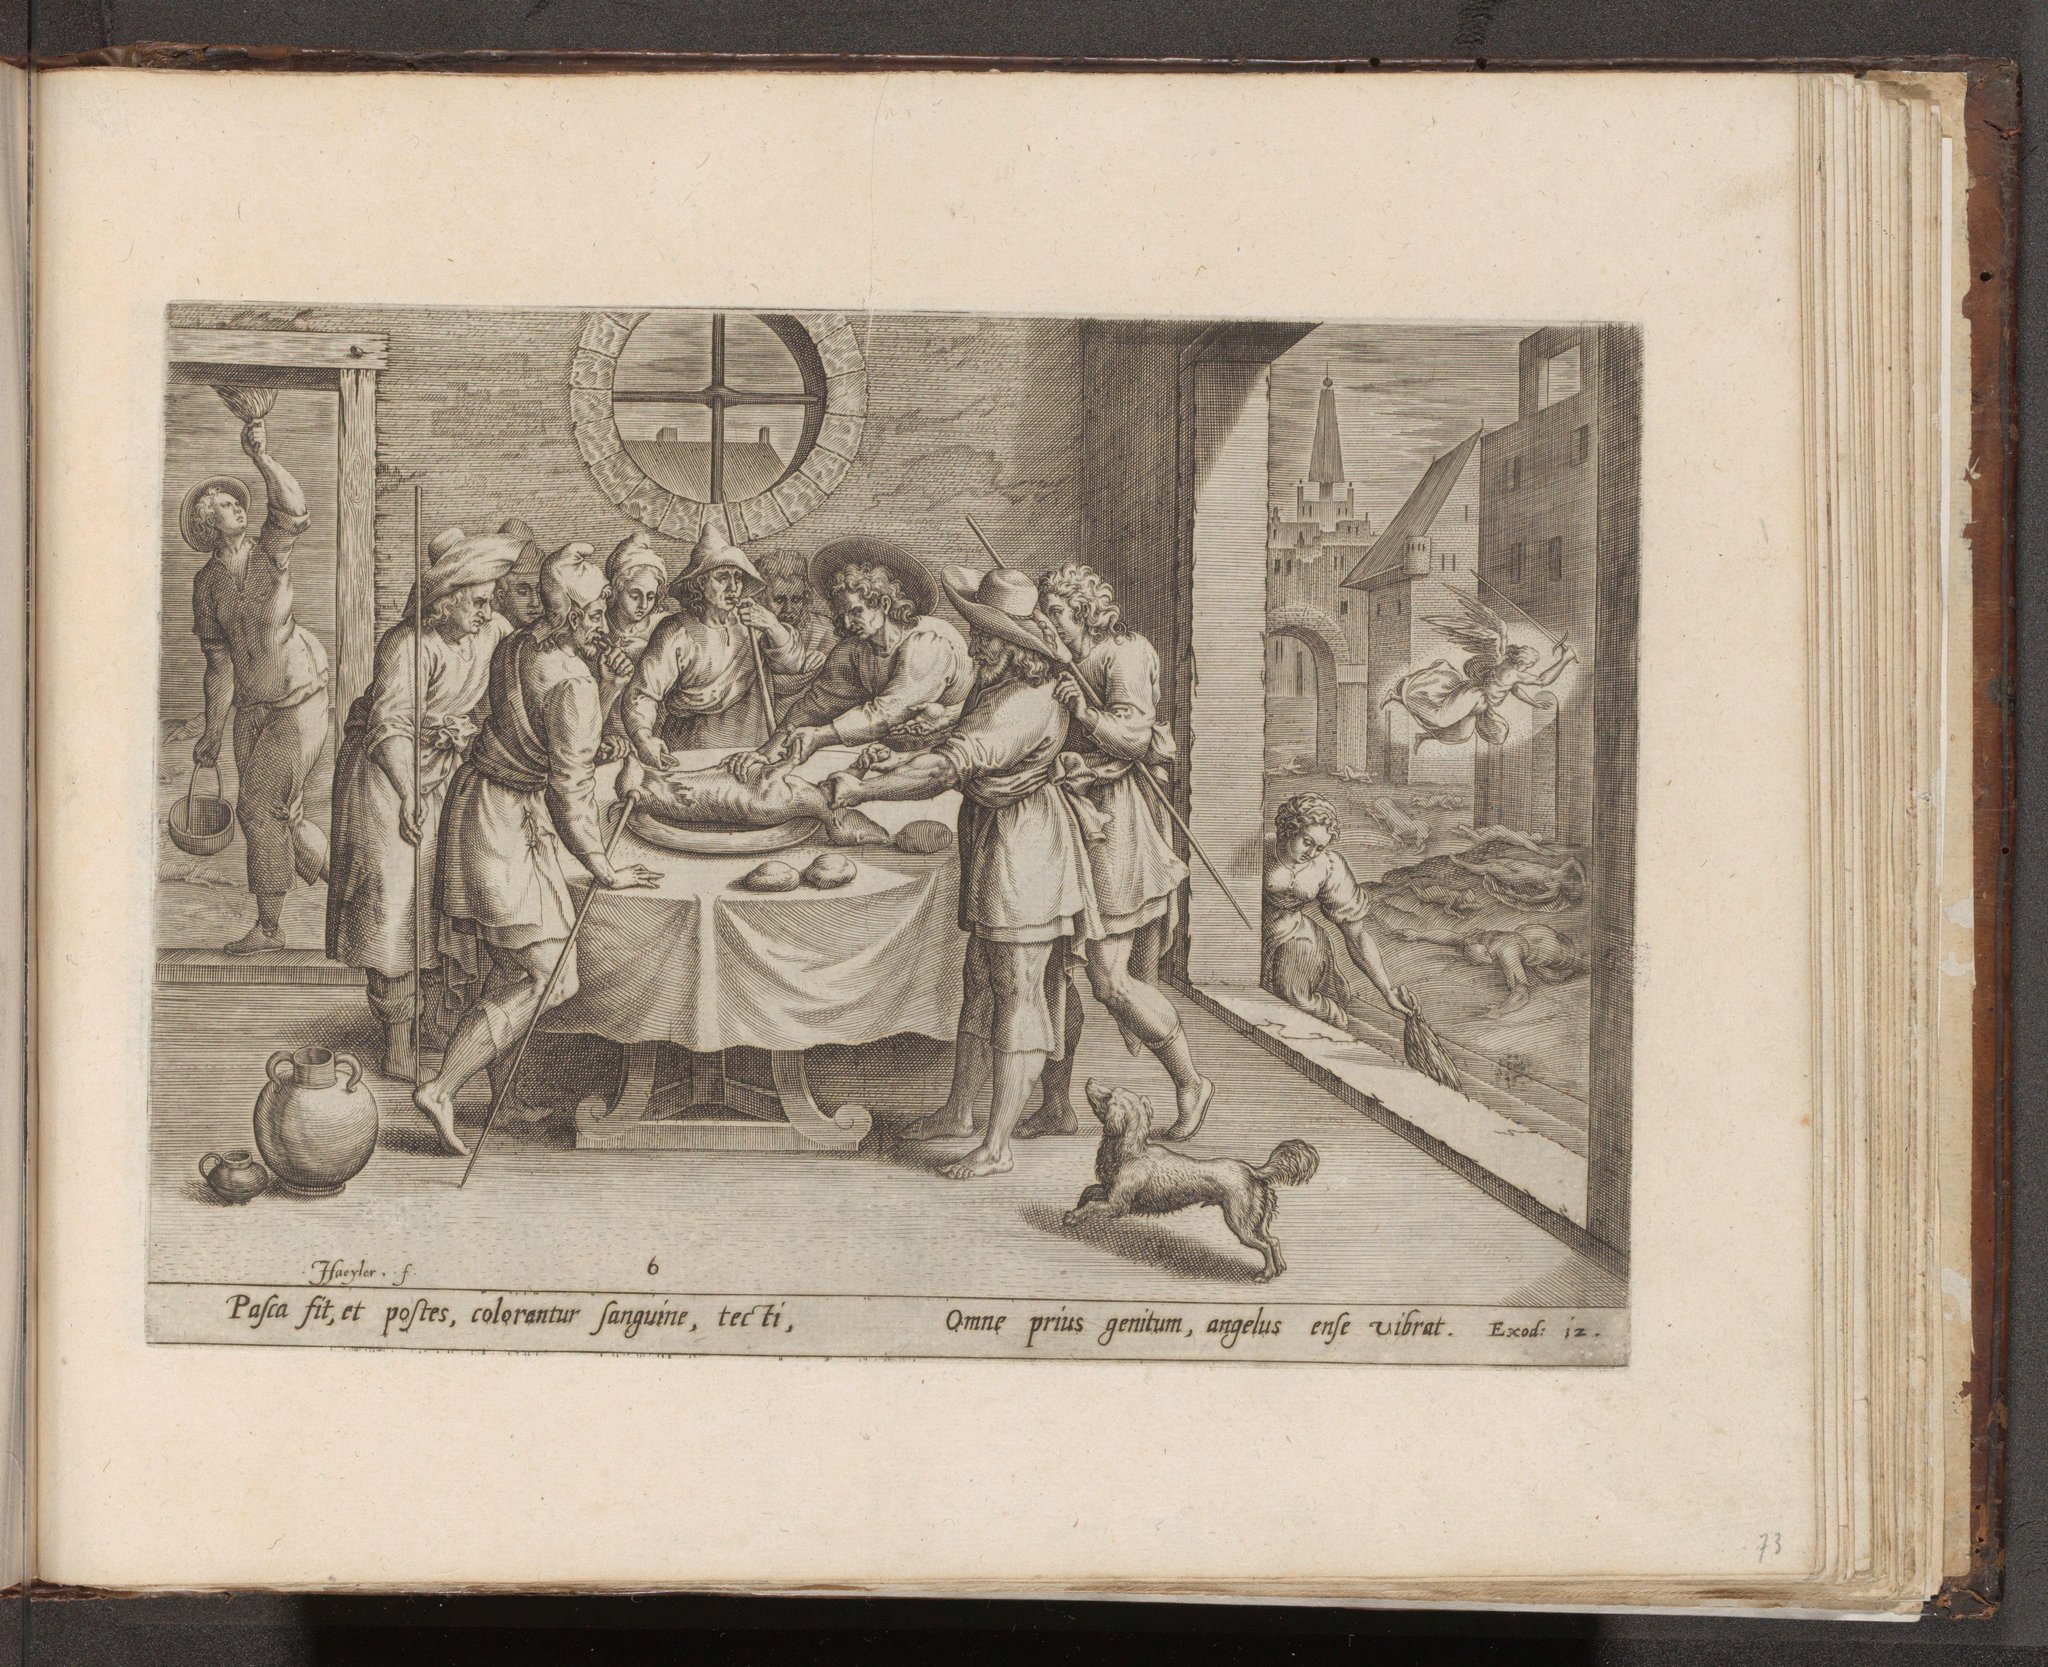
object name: album leaf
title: Thesaurus sacrarum historiaru[m] veteris testame[n]ti, elega[n]tissimis imaginibus expressu[m] excelle[n]tissimoru[m] in hac arte viroru[m] opera: nu[n]c primu[m] in luce[m] editus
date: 1579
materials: paper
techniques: engraving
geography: antwerp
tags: with lamb's blood the israelites make marks (usually tau-crosses) on the doorposts of their houses, the israelites eat the passover lamb standing about a table with their loins girt, their shoes on their feet and with staves in their hands, ready to depart, the plague of the first-born: the destroying angel passes through the land and kills every egyptian first-born of man and animal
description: Op de voorgrond een Joodse familie rond een tafel met het pesachoffer: een geslacht lam. De deuren van Joodse huizen worden met lamsbloed gemarkeerd. Rechts de tiende plaag van Egypte: een doodsengel doodt alle eerstgeborenen van Egypte, maar gaat voorbij aan de huizen met bloed aan de deurposten. Onder de voorstelling een verwijzing in het Latijn naar de Bijbeltekst in Ex. 12. Prent maakt deel uit van een album.